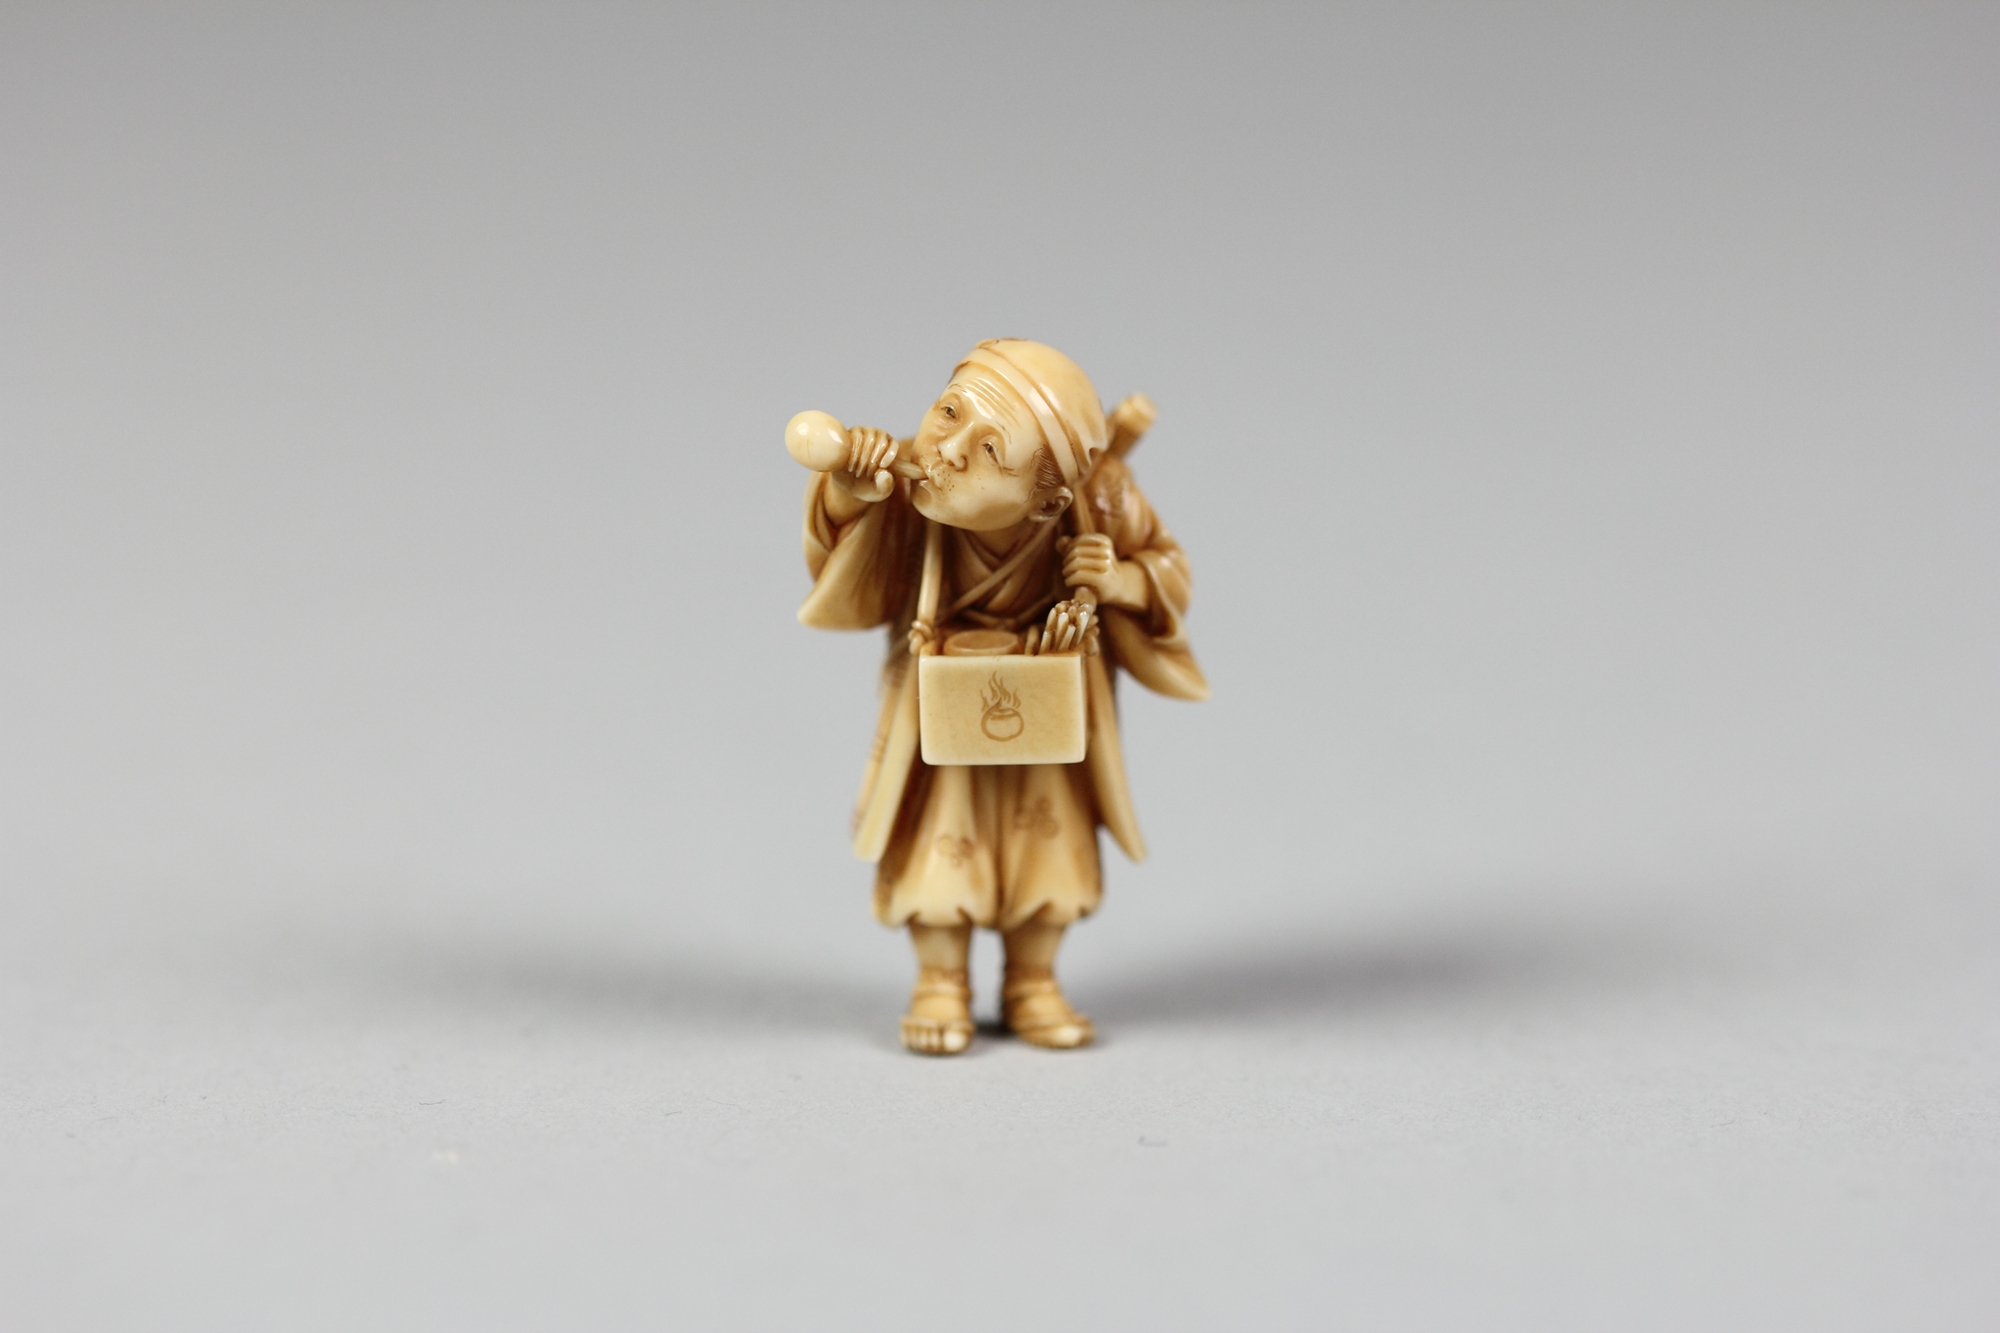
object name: netsuke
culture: japanese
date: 1801-1900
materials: ivory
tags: human figures